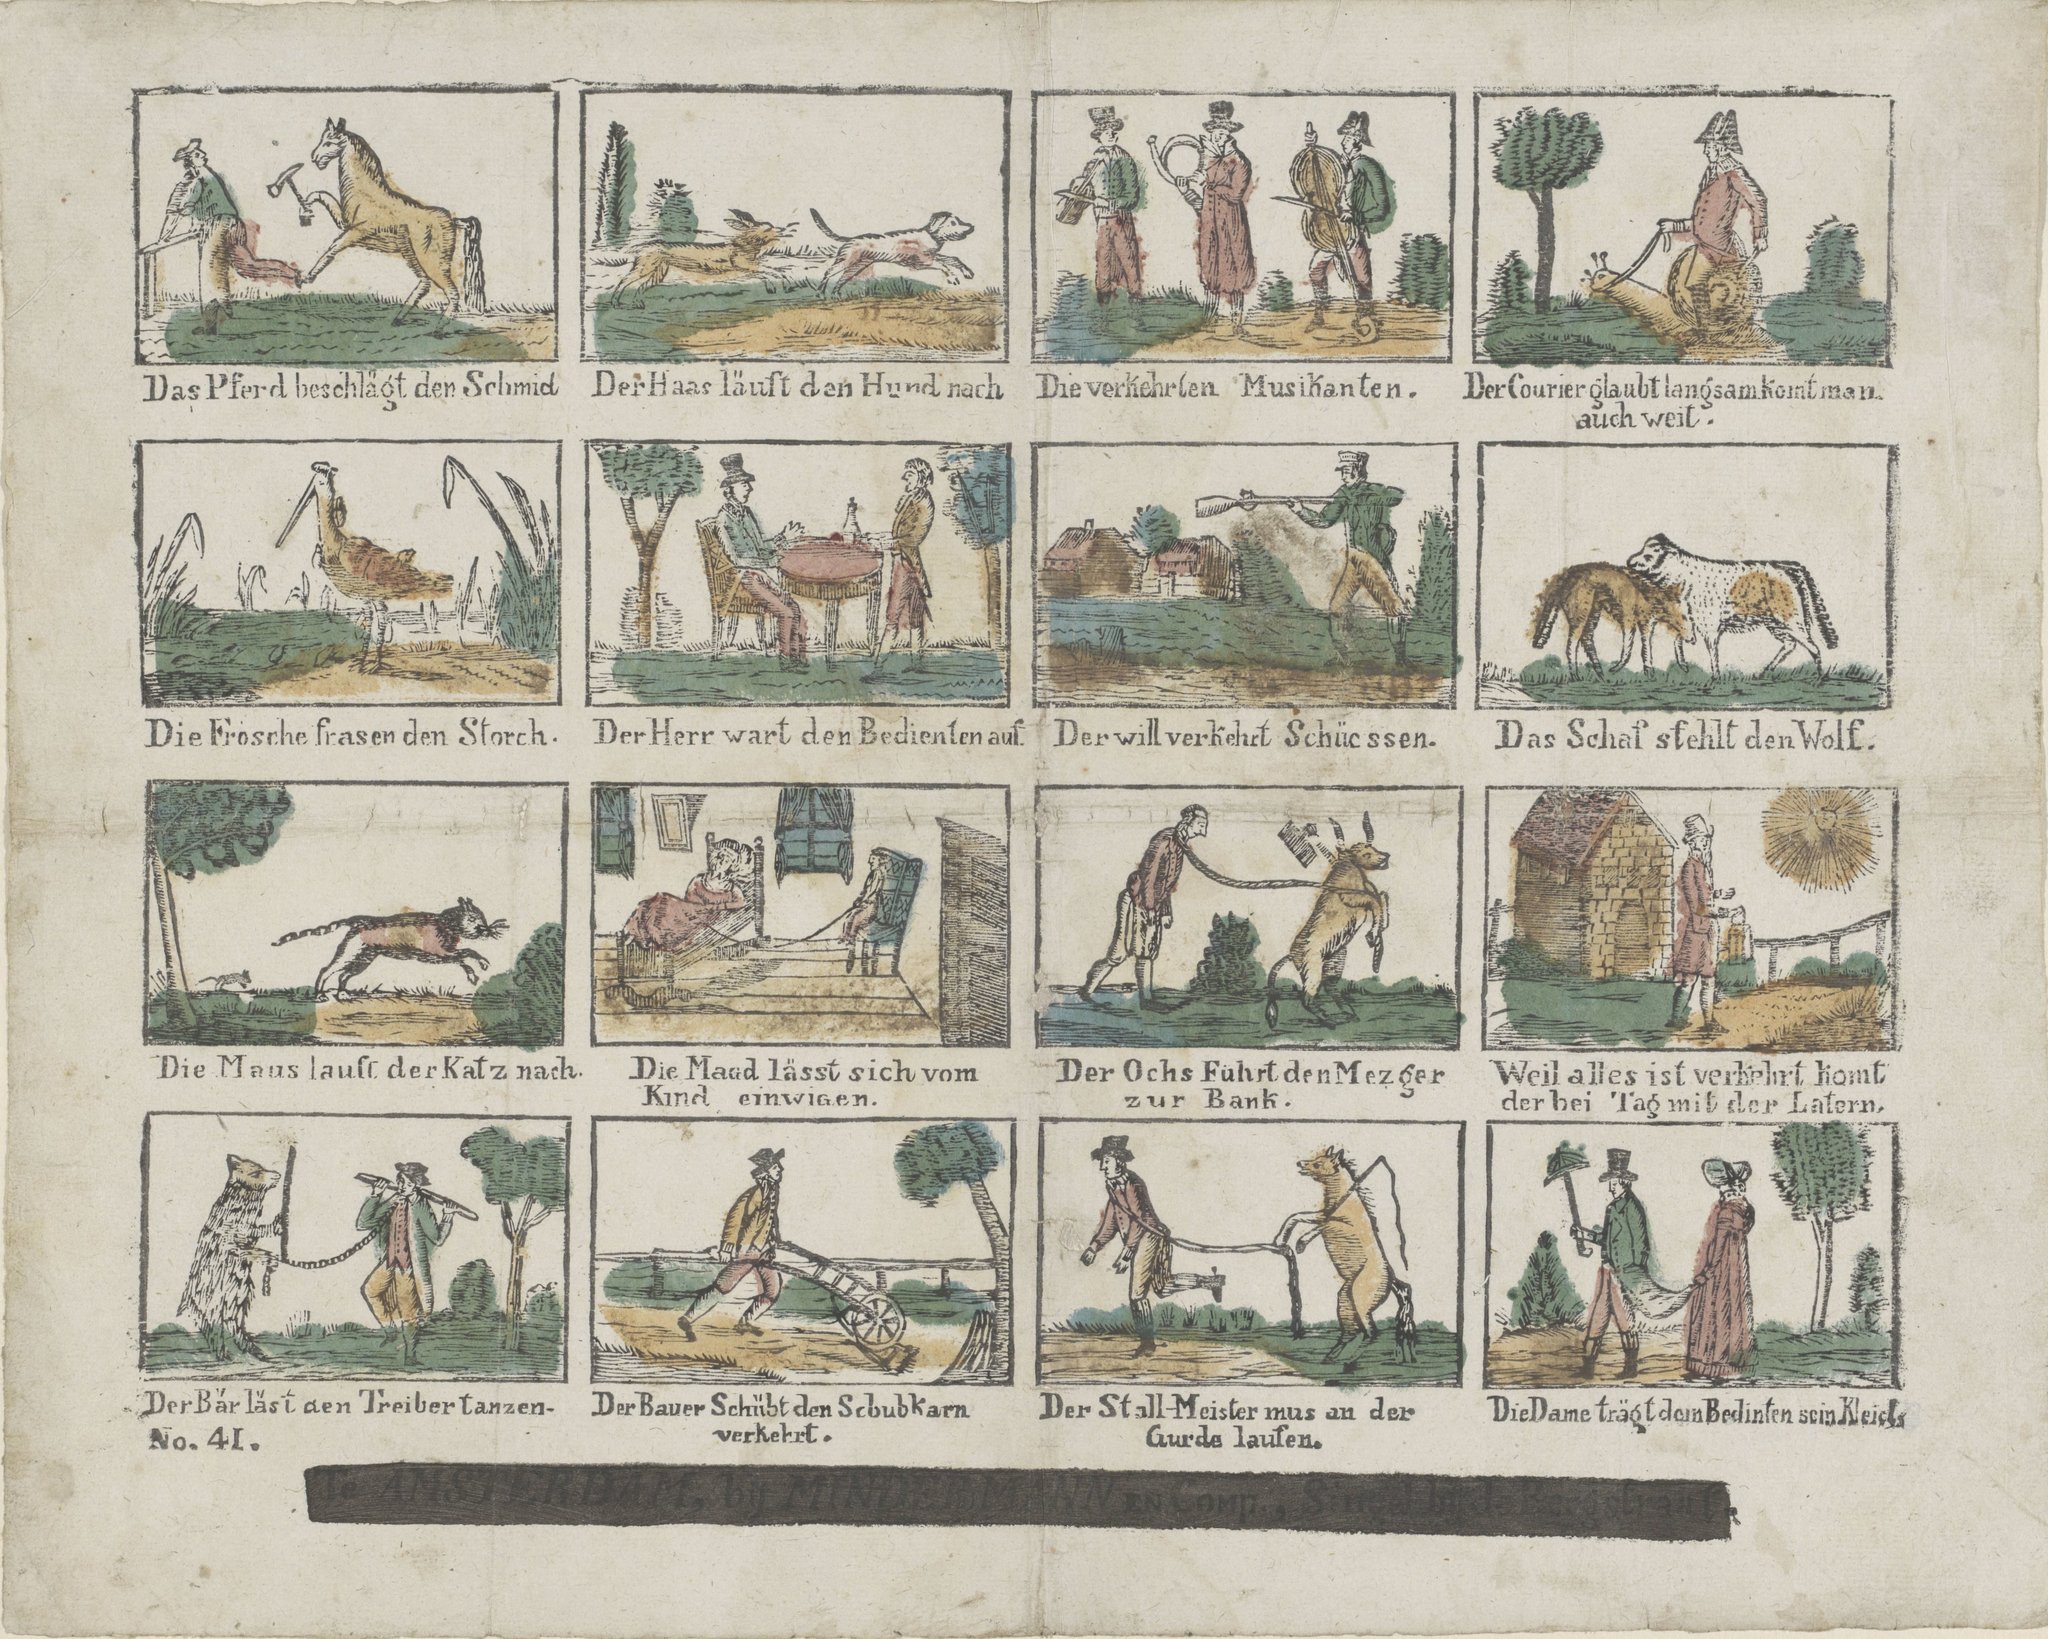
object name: print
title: Verkeerde wereld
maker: Anonymous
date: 1700-1899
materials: paper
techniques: colour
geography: netherlands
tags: 'mundus inversus', the reversed world, the topsy-turvy world, 'le monde bestourné', animals acting as human beings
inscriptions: collector's mark: Lugt 2760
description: Blad met 16 voorstellingen van de verkeerde wereld, waar onder andere dieren zich als mensen gedragen. Onder elke afbeelding tekst. Genummerd linksonder: No. 41.